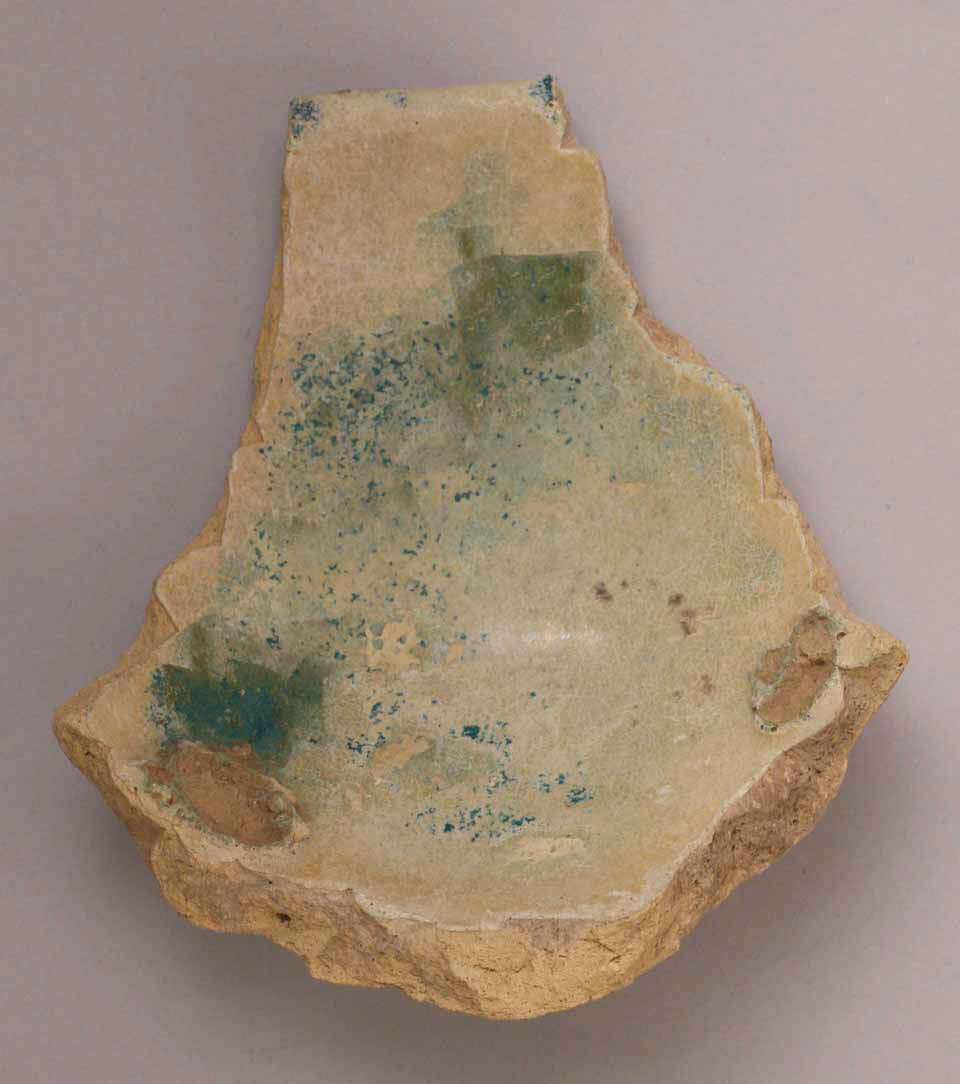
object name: fragment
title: Ceramic Fragment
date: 201-800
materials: earthenware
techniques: glazing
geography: iraq